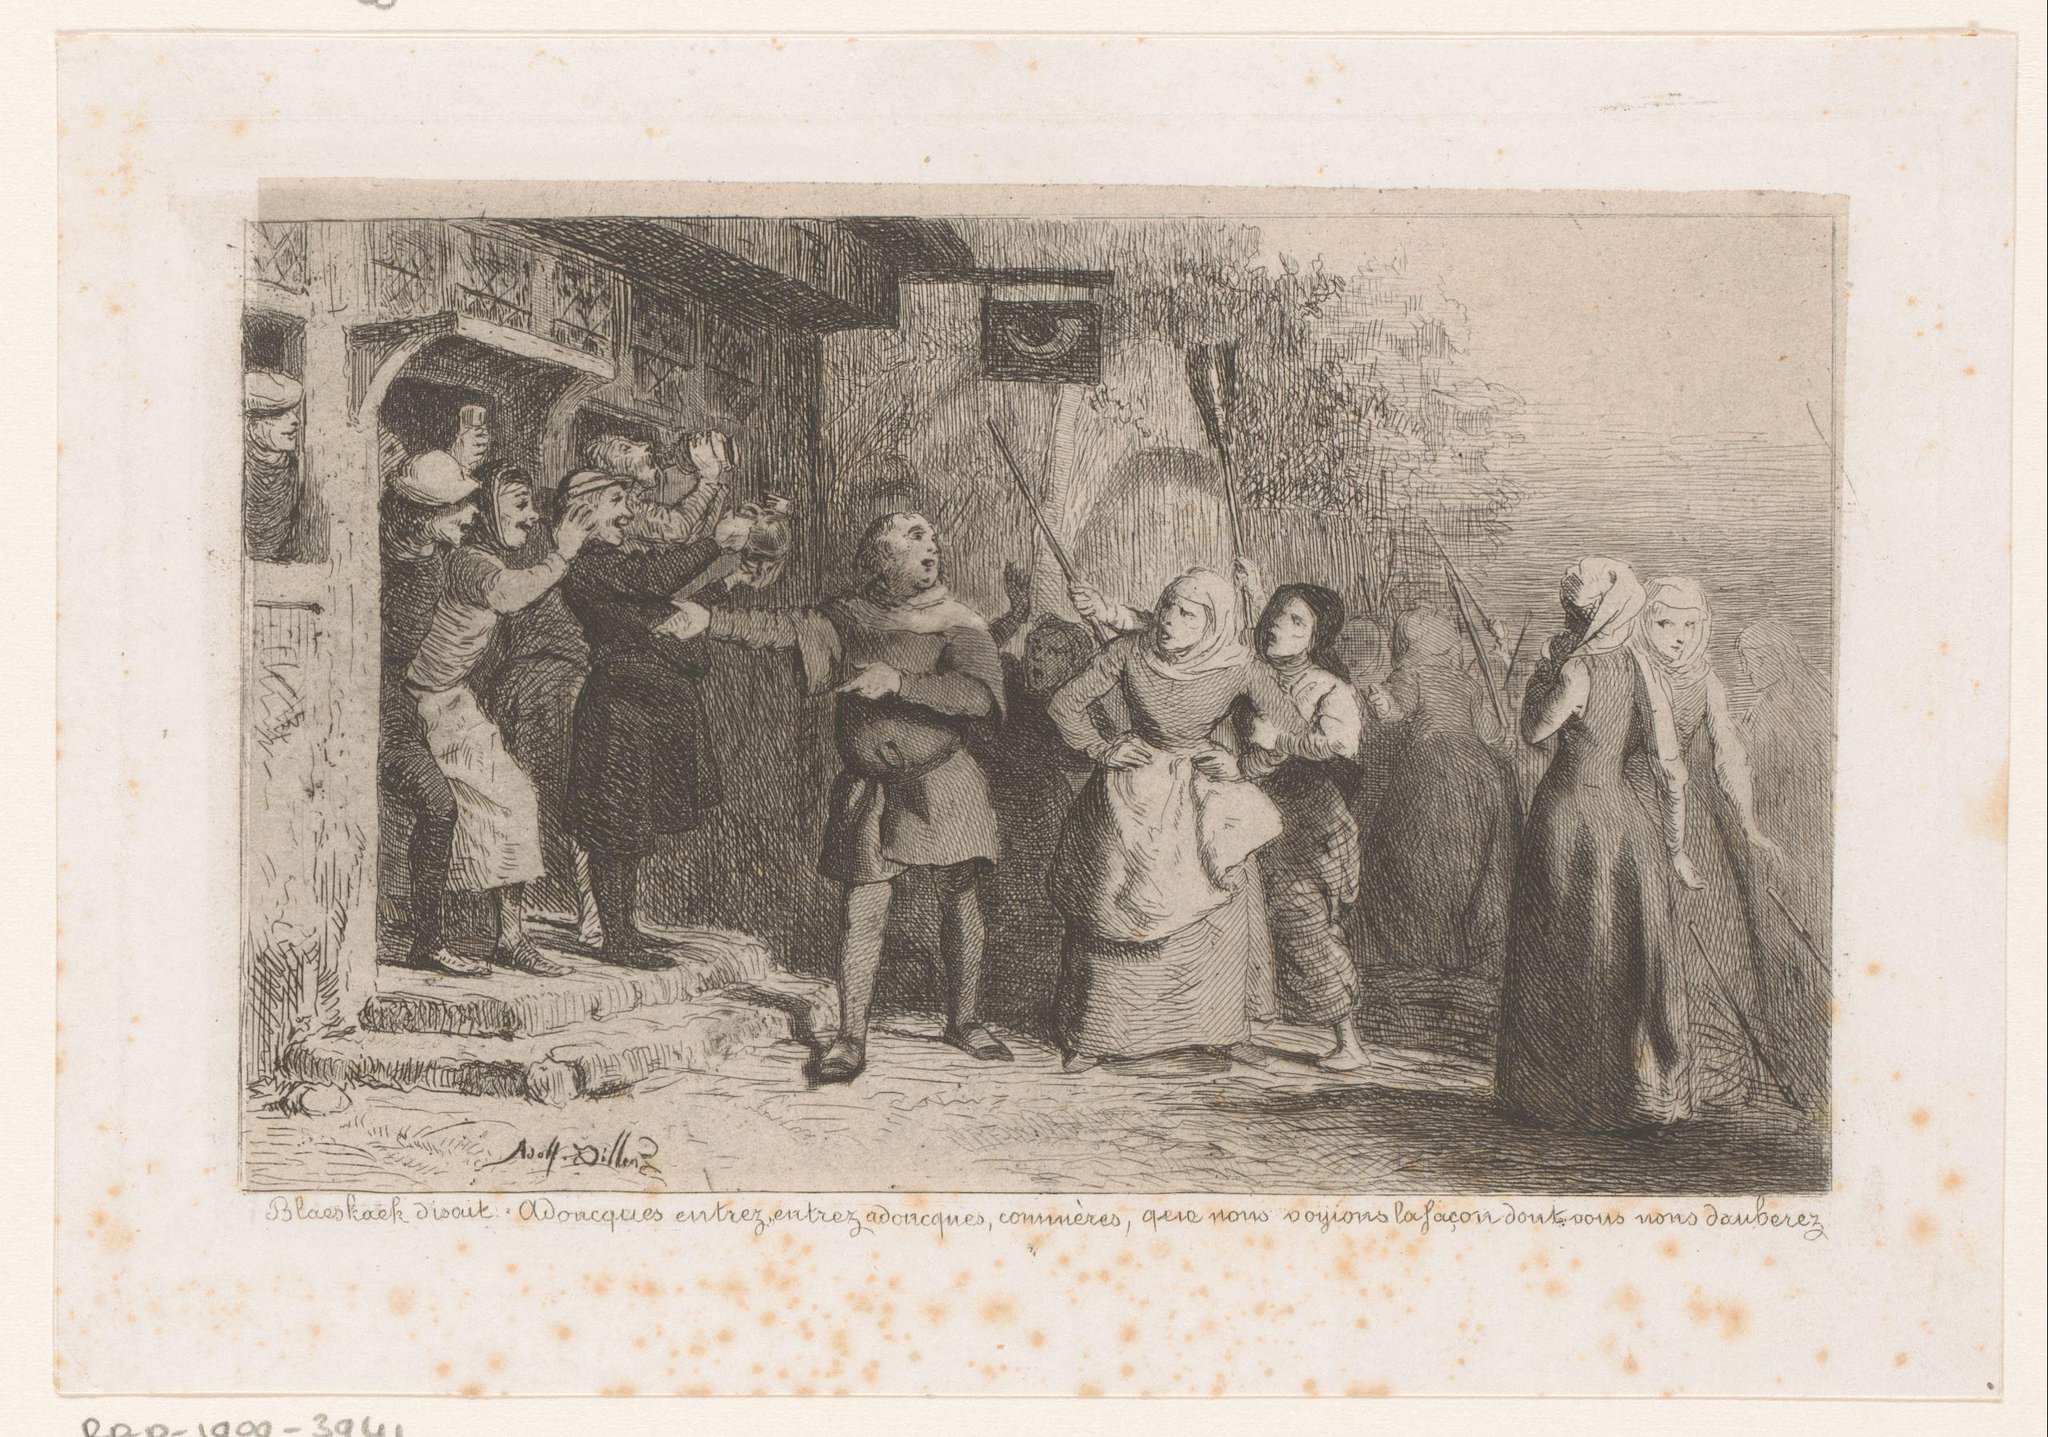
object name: book illustration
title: Menigte vrouwen voor een herberg met drinkers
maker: adolphe alexandre dillens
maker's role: draughtsman, painter, print maker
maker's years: 1821-1877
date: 1861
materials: paper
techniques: etching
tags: crowd, mob, hotel, hostelry, inn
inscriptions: collector's mark: Lugt 2228, collector's mark: Lugt 1485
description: Prent uit: Coster, Charles de. Légendes flamandes. S.l.: Parent et Fils, 1861.